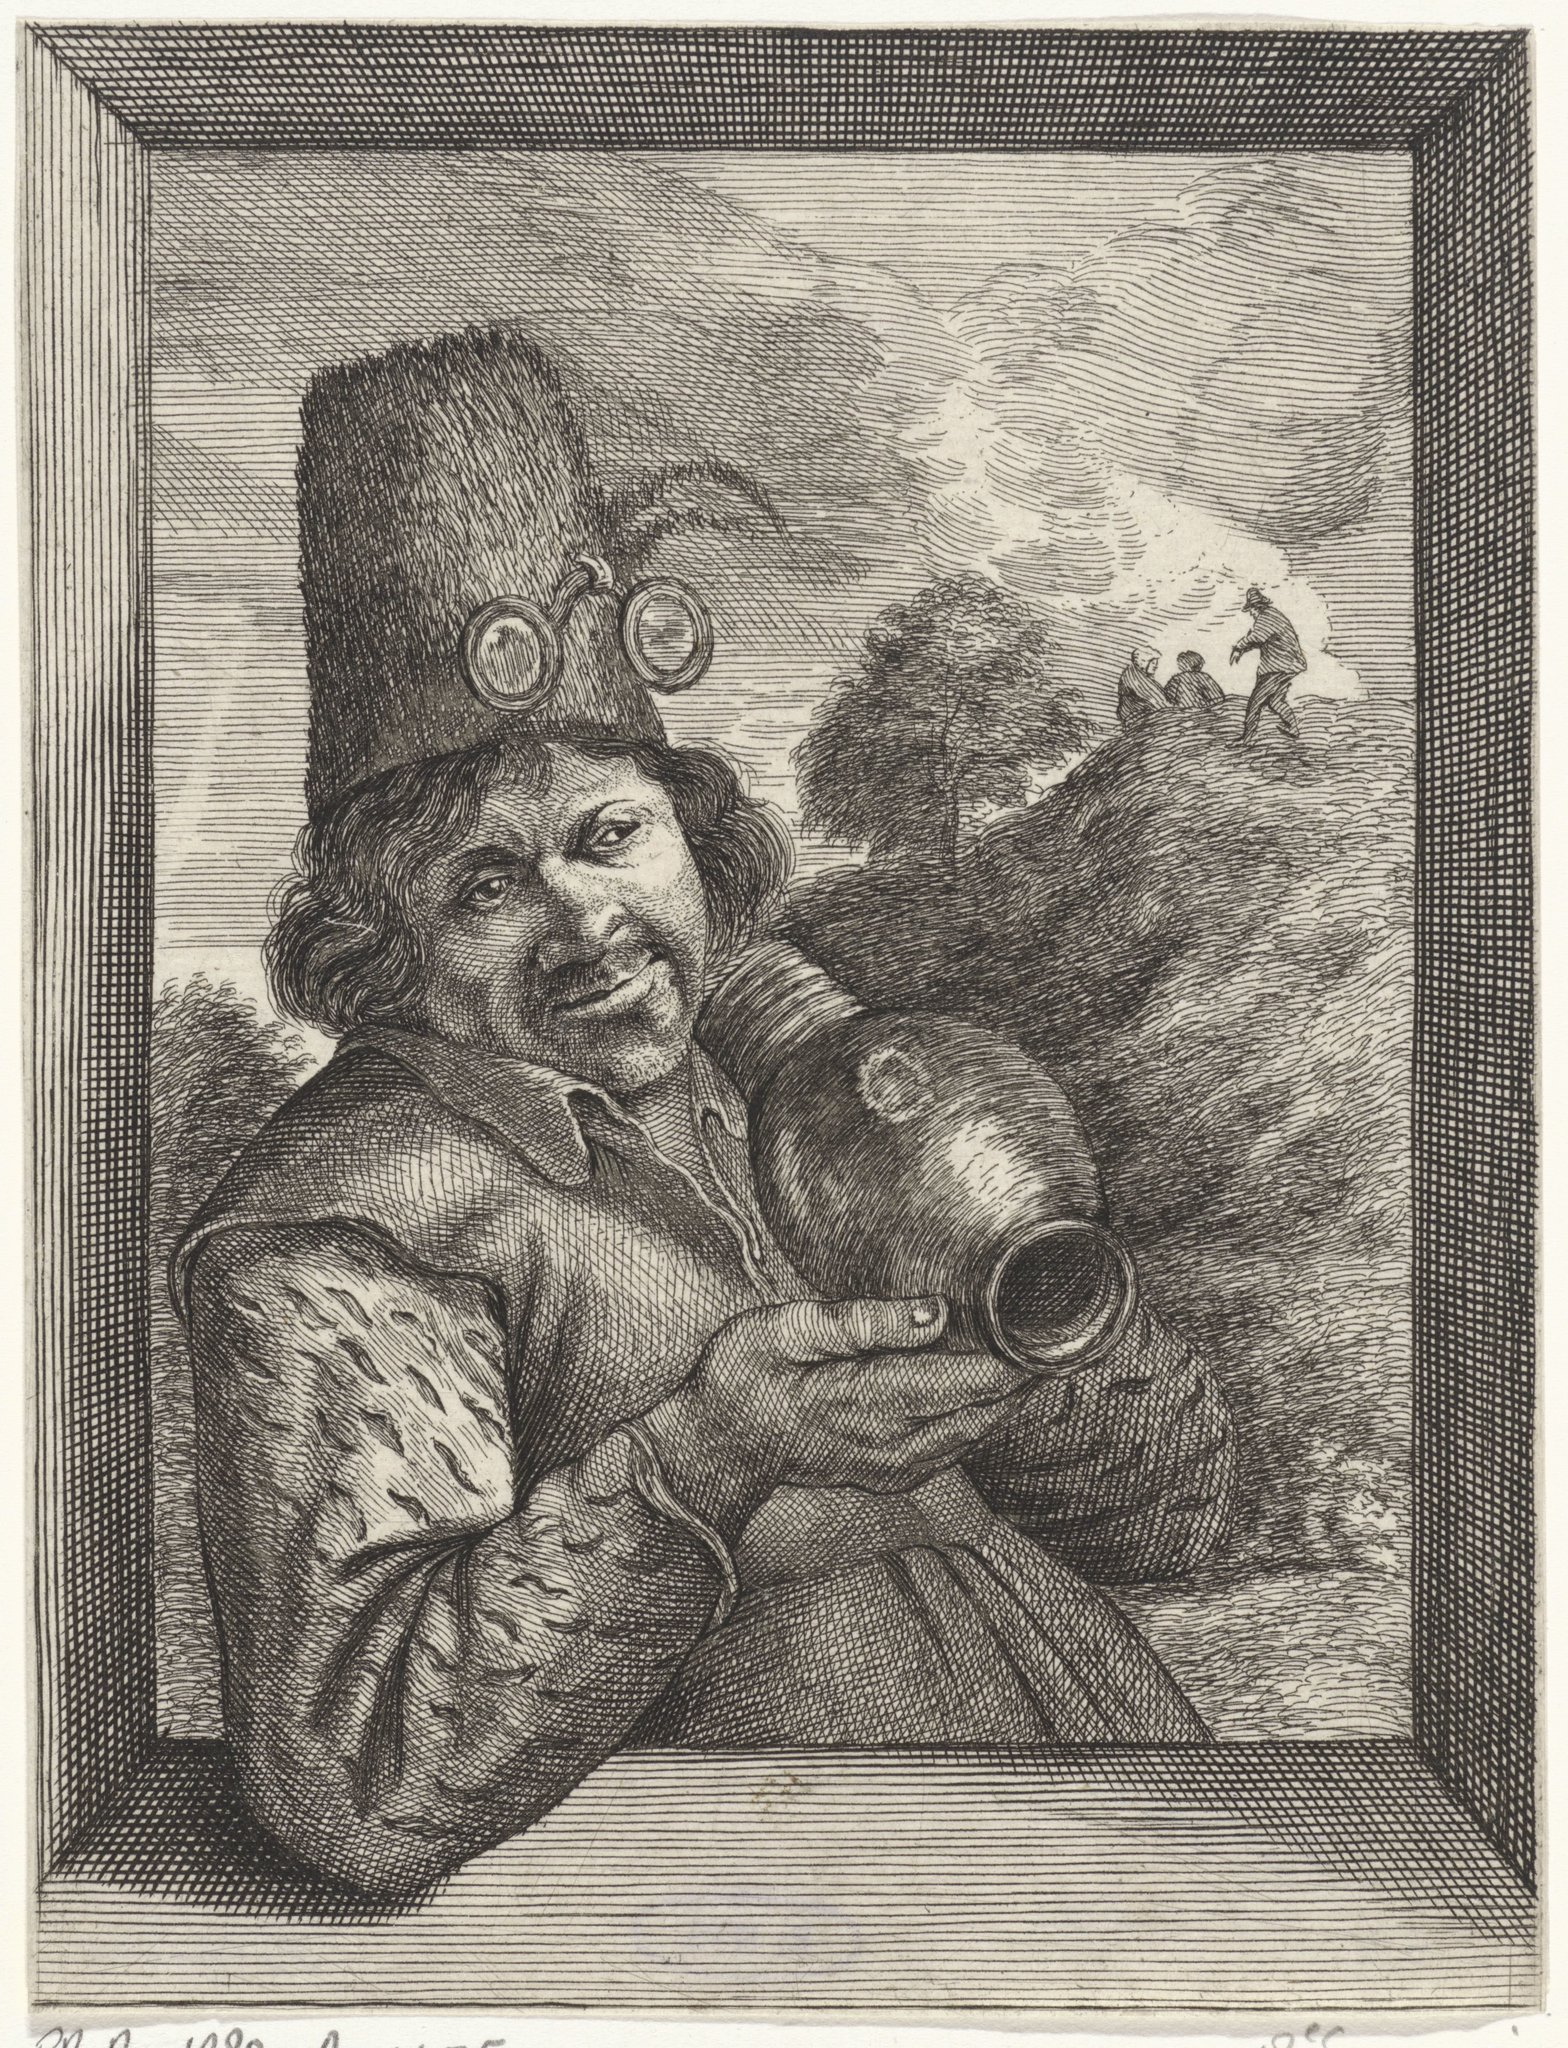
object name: print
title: Gezicht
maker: conrad lauwers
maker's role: print maker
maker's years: 1632-1685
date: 1642-1685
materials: paper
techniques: etching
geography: antwerp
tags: eyeglasses, spectacles, sight, looking (one of the five senses), head-gear: cap (+ men's clothes), container of ceramics: jar, jug, pot, vase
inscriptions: collector's mark: Lugt 2228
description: In een venster staat een boer met een hoge muts op het hoofd. Aan de muts is een bril bevestigd. De man lijkt door een kruik zonder bodem te kijken. Op de achtergrond drie figuren op een heuvel. Een verbeelding van zicht, een van de vijf zintuigen.